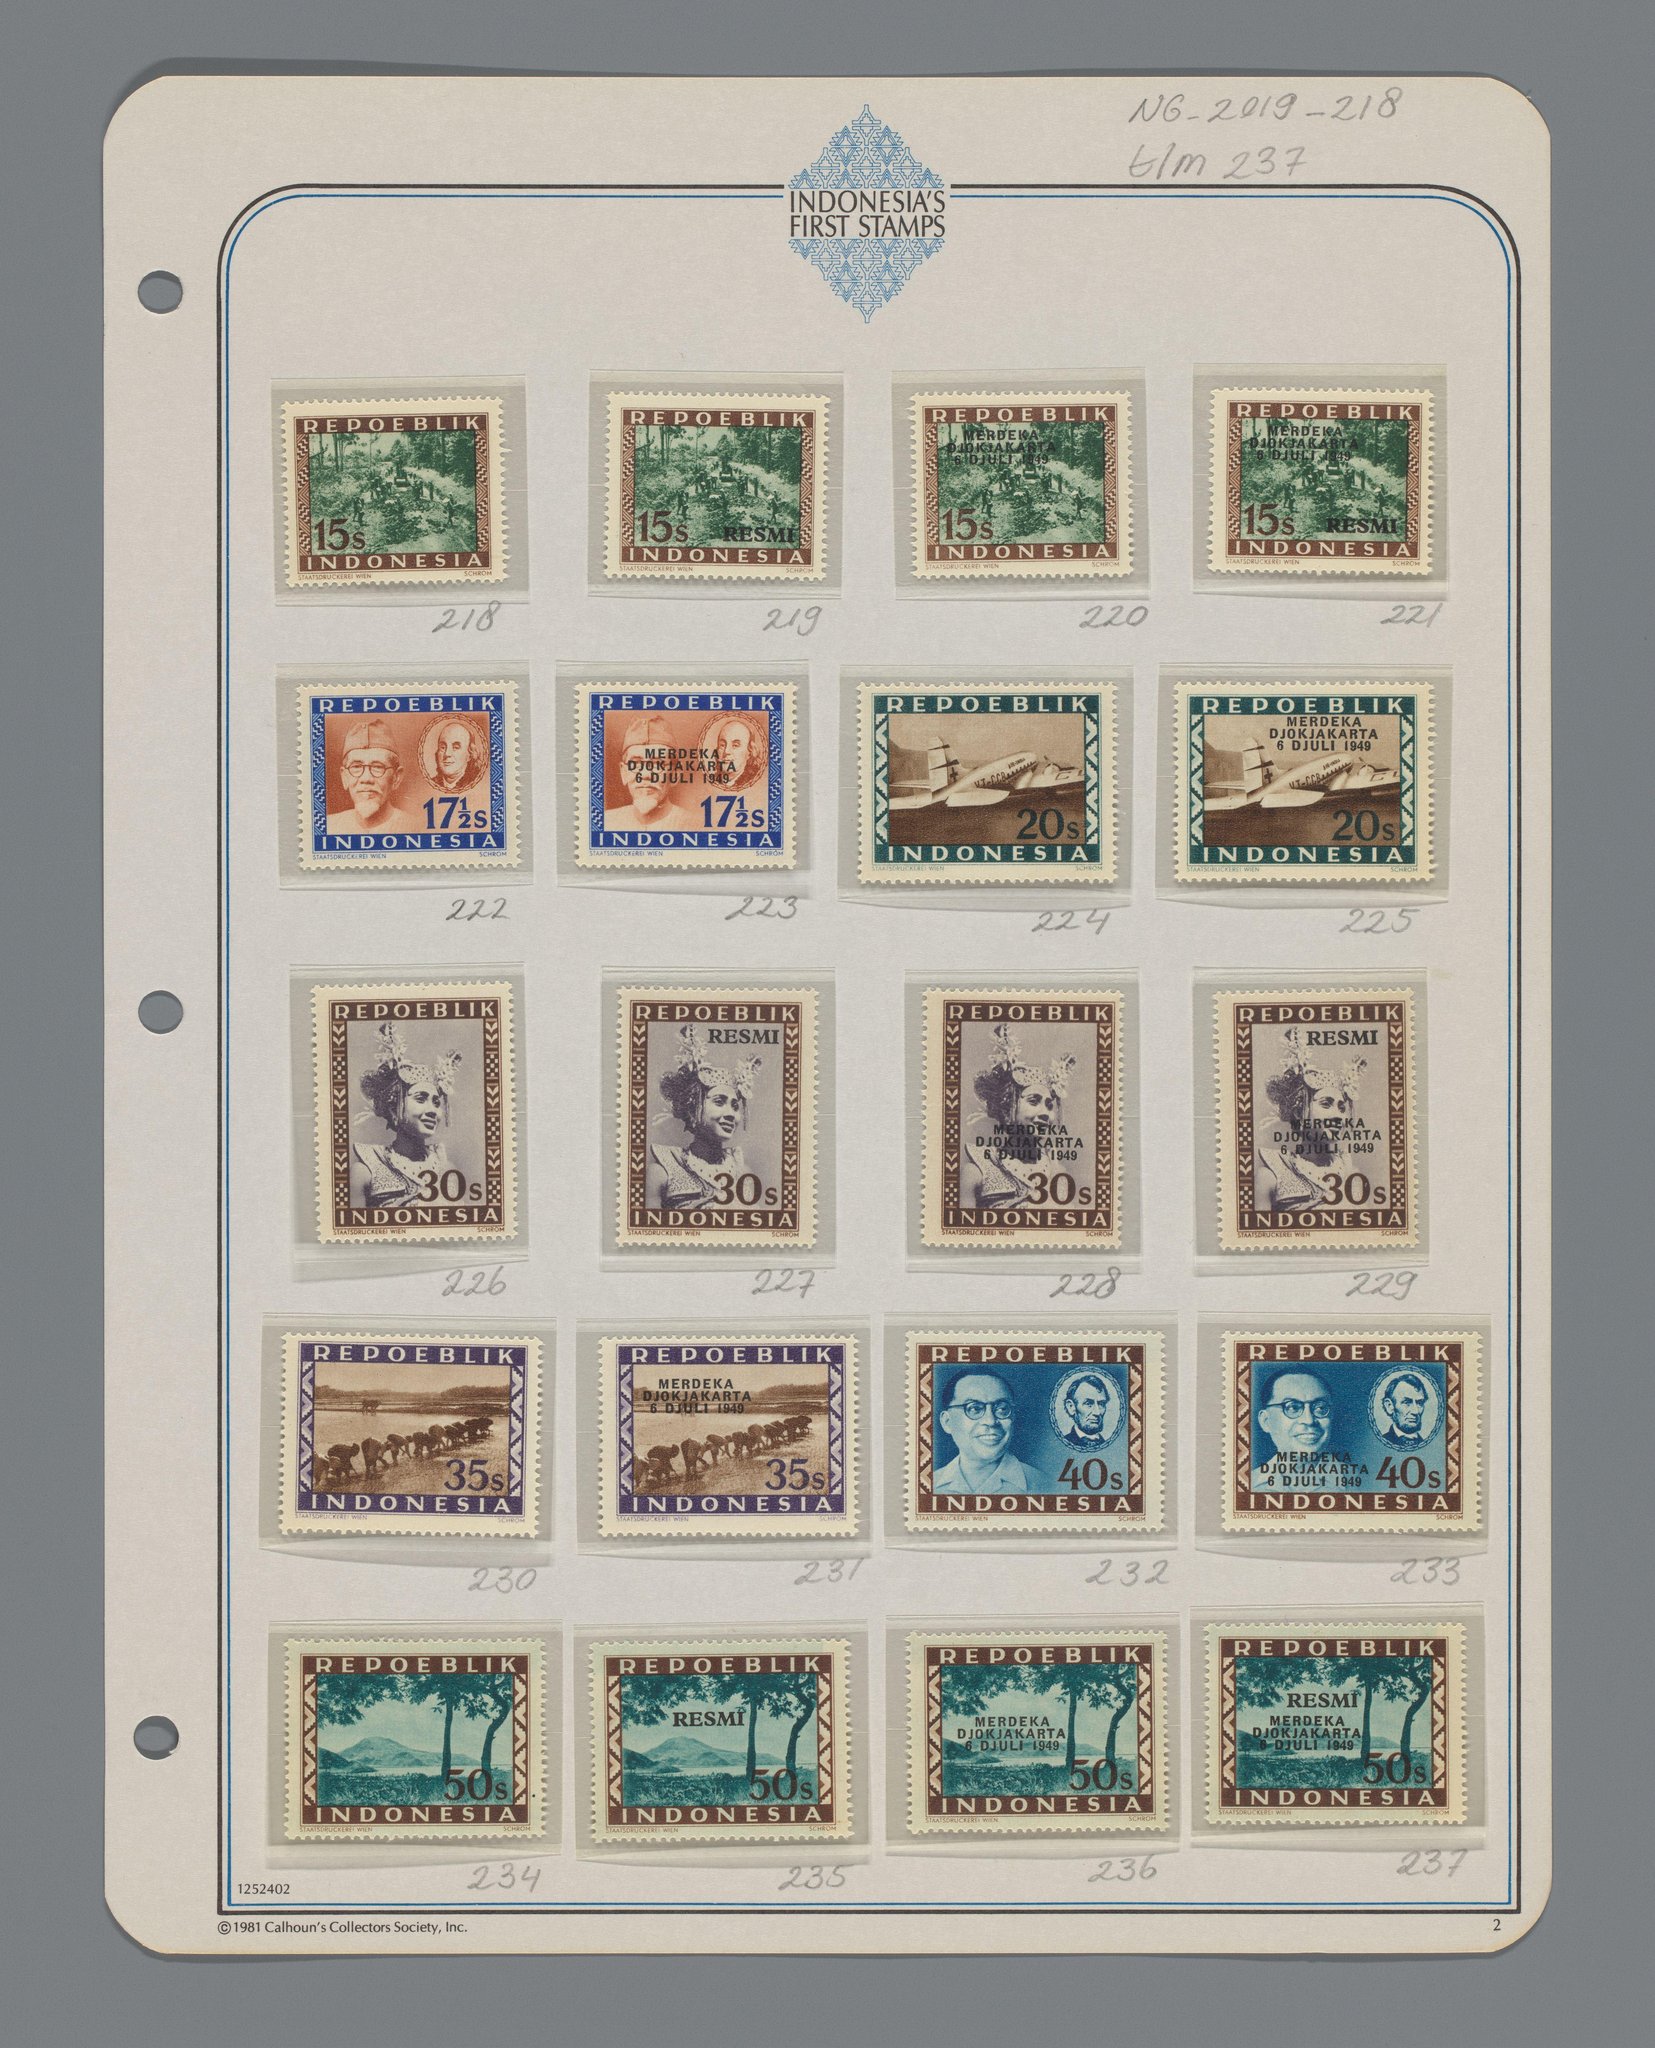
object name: postage stamp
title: Postzegel Republik Indonesia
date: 1949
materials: paper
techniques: photoaquatint, engraving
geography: vienna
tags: indonesia